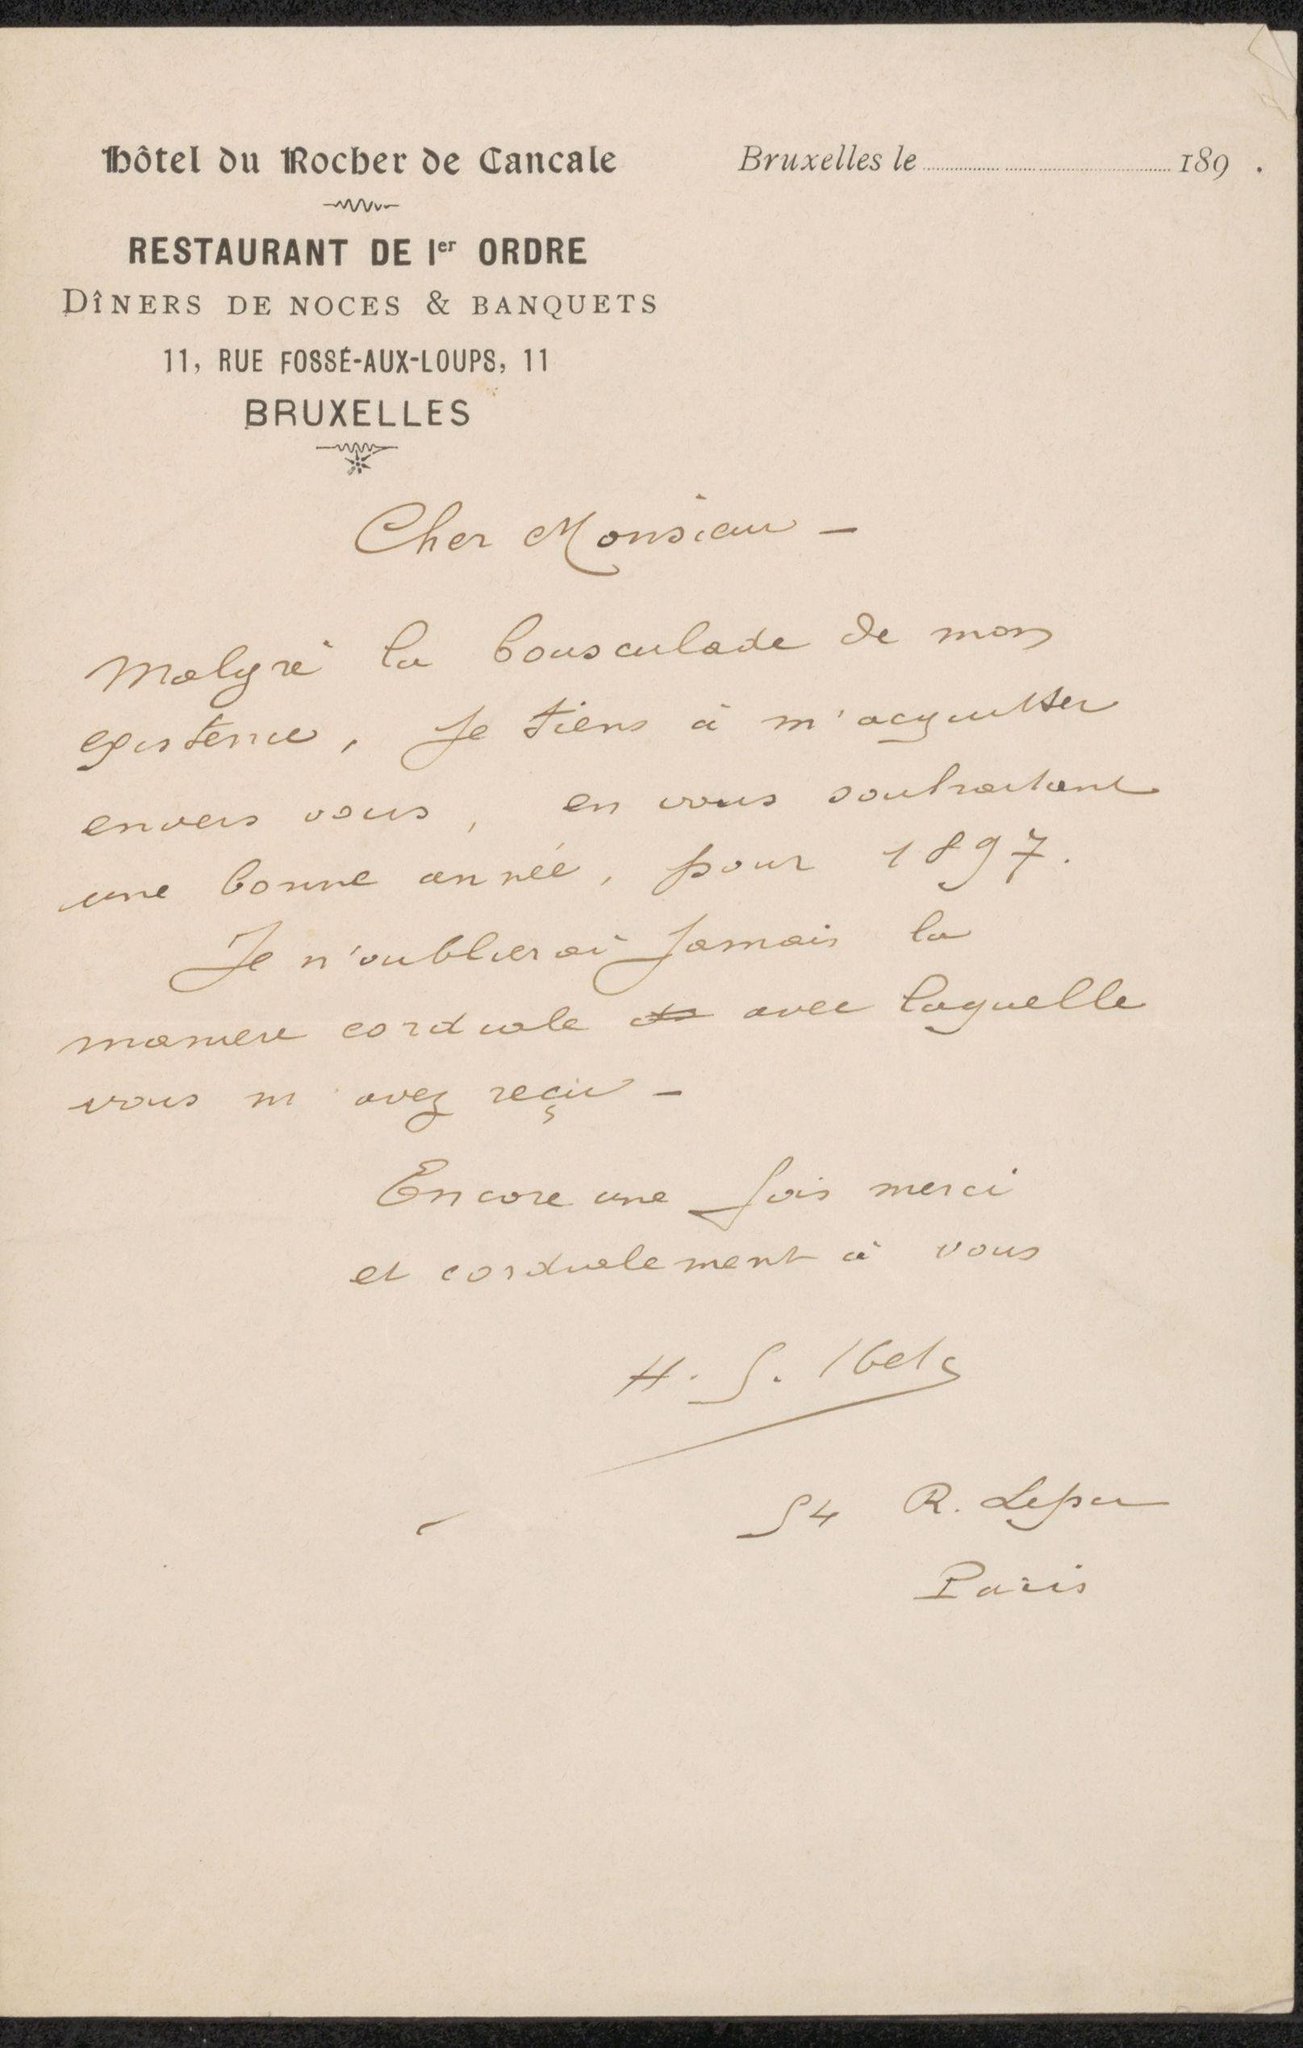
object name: letter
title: Brief aan Pieter Haverkorn van Rijsewijk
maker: henri gabriel ibels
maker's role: print maker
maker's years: 1867-1936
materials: ink, paper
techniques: pen, printing, writing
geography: paris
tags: pieter haverkorn van rijsewijk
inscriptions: watermark